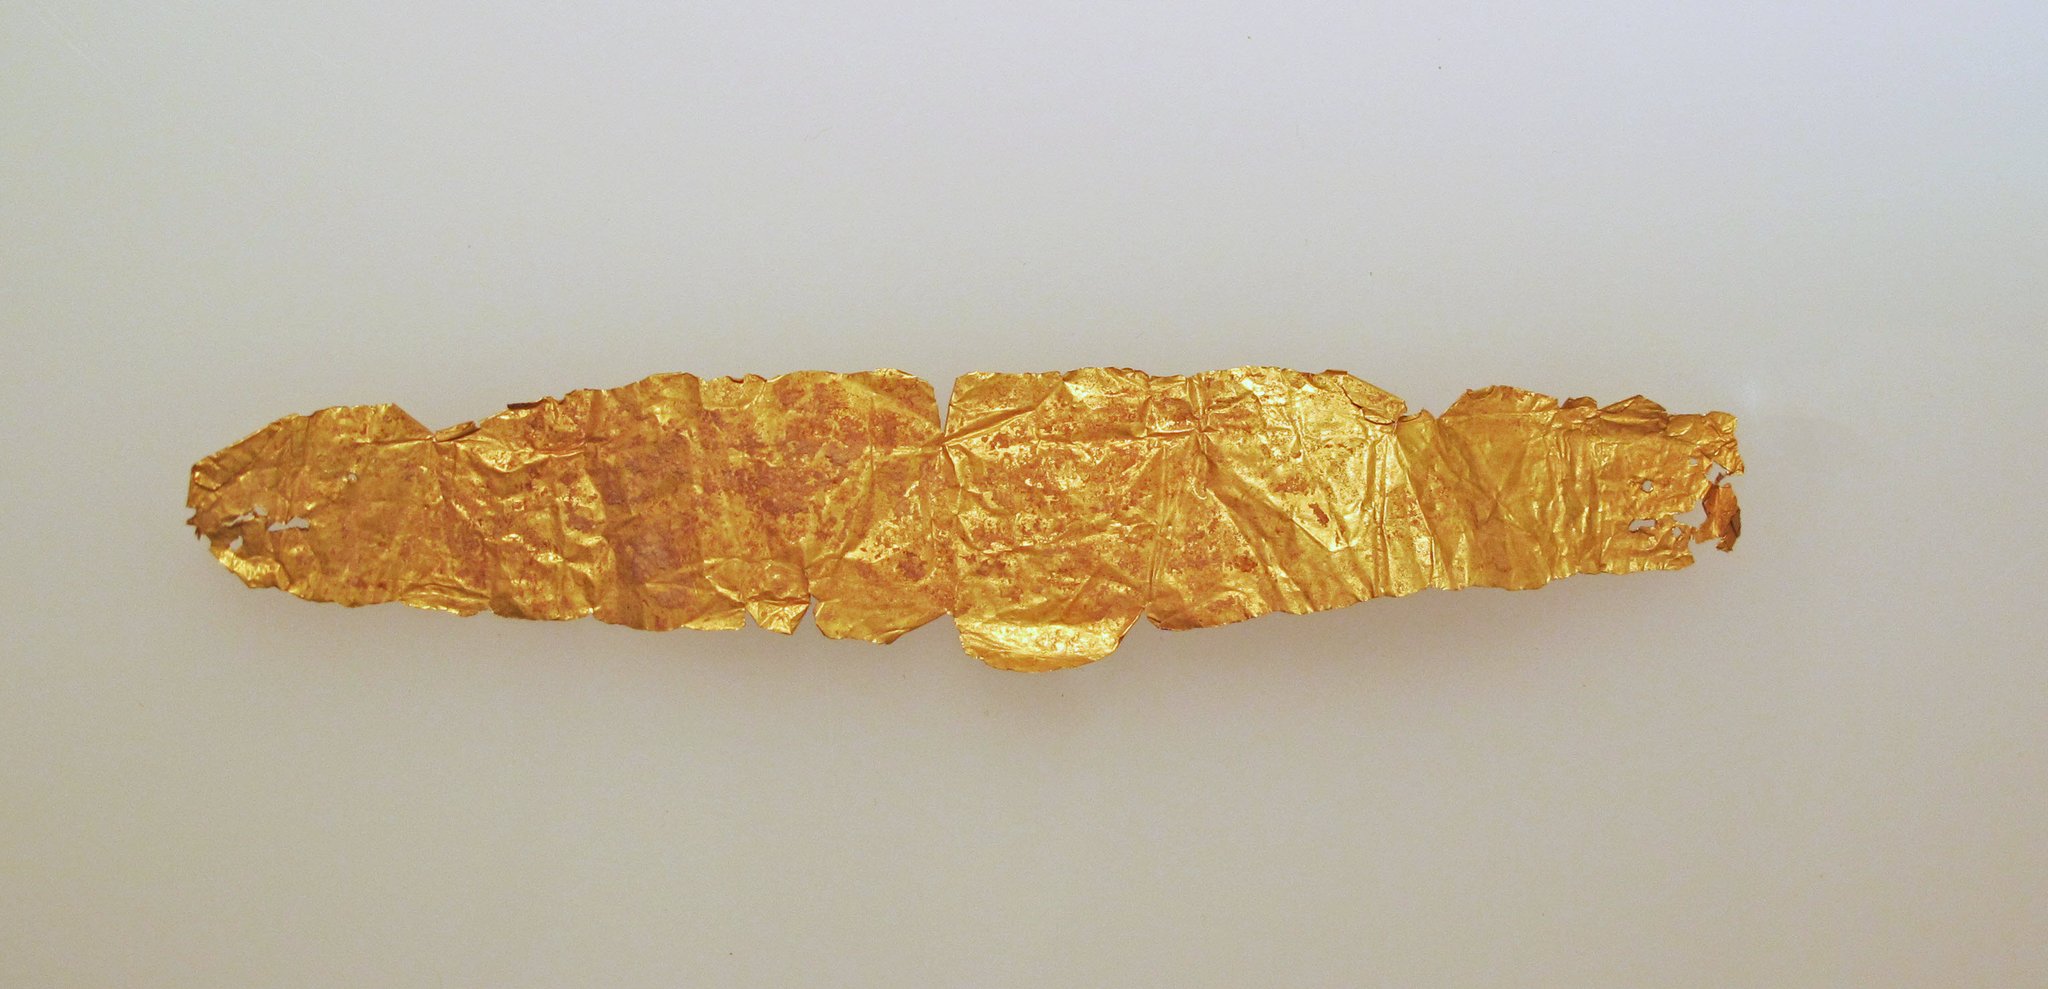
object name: frontlet of gold leaf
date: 7000 BCE-330 CE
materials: gold